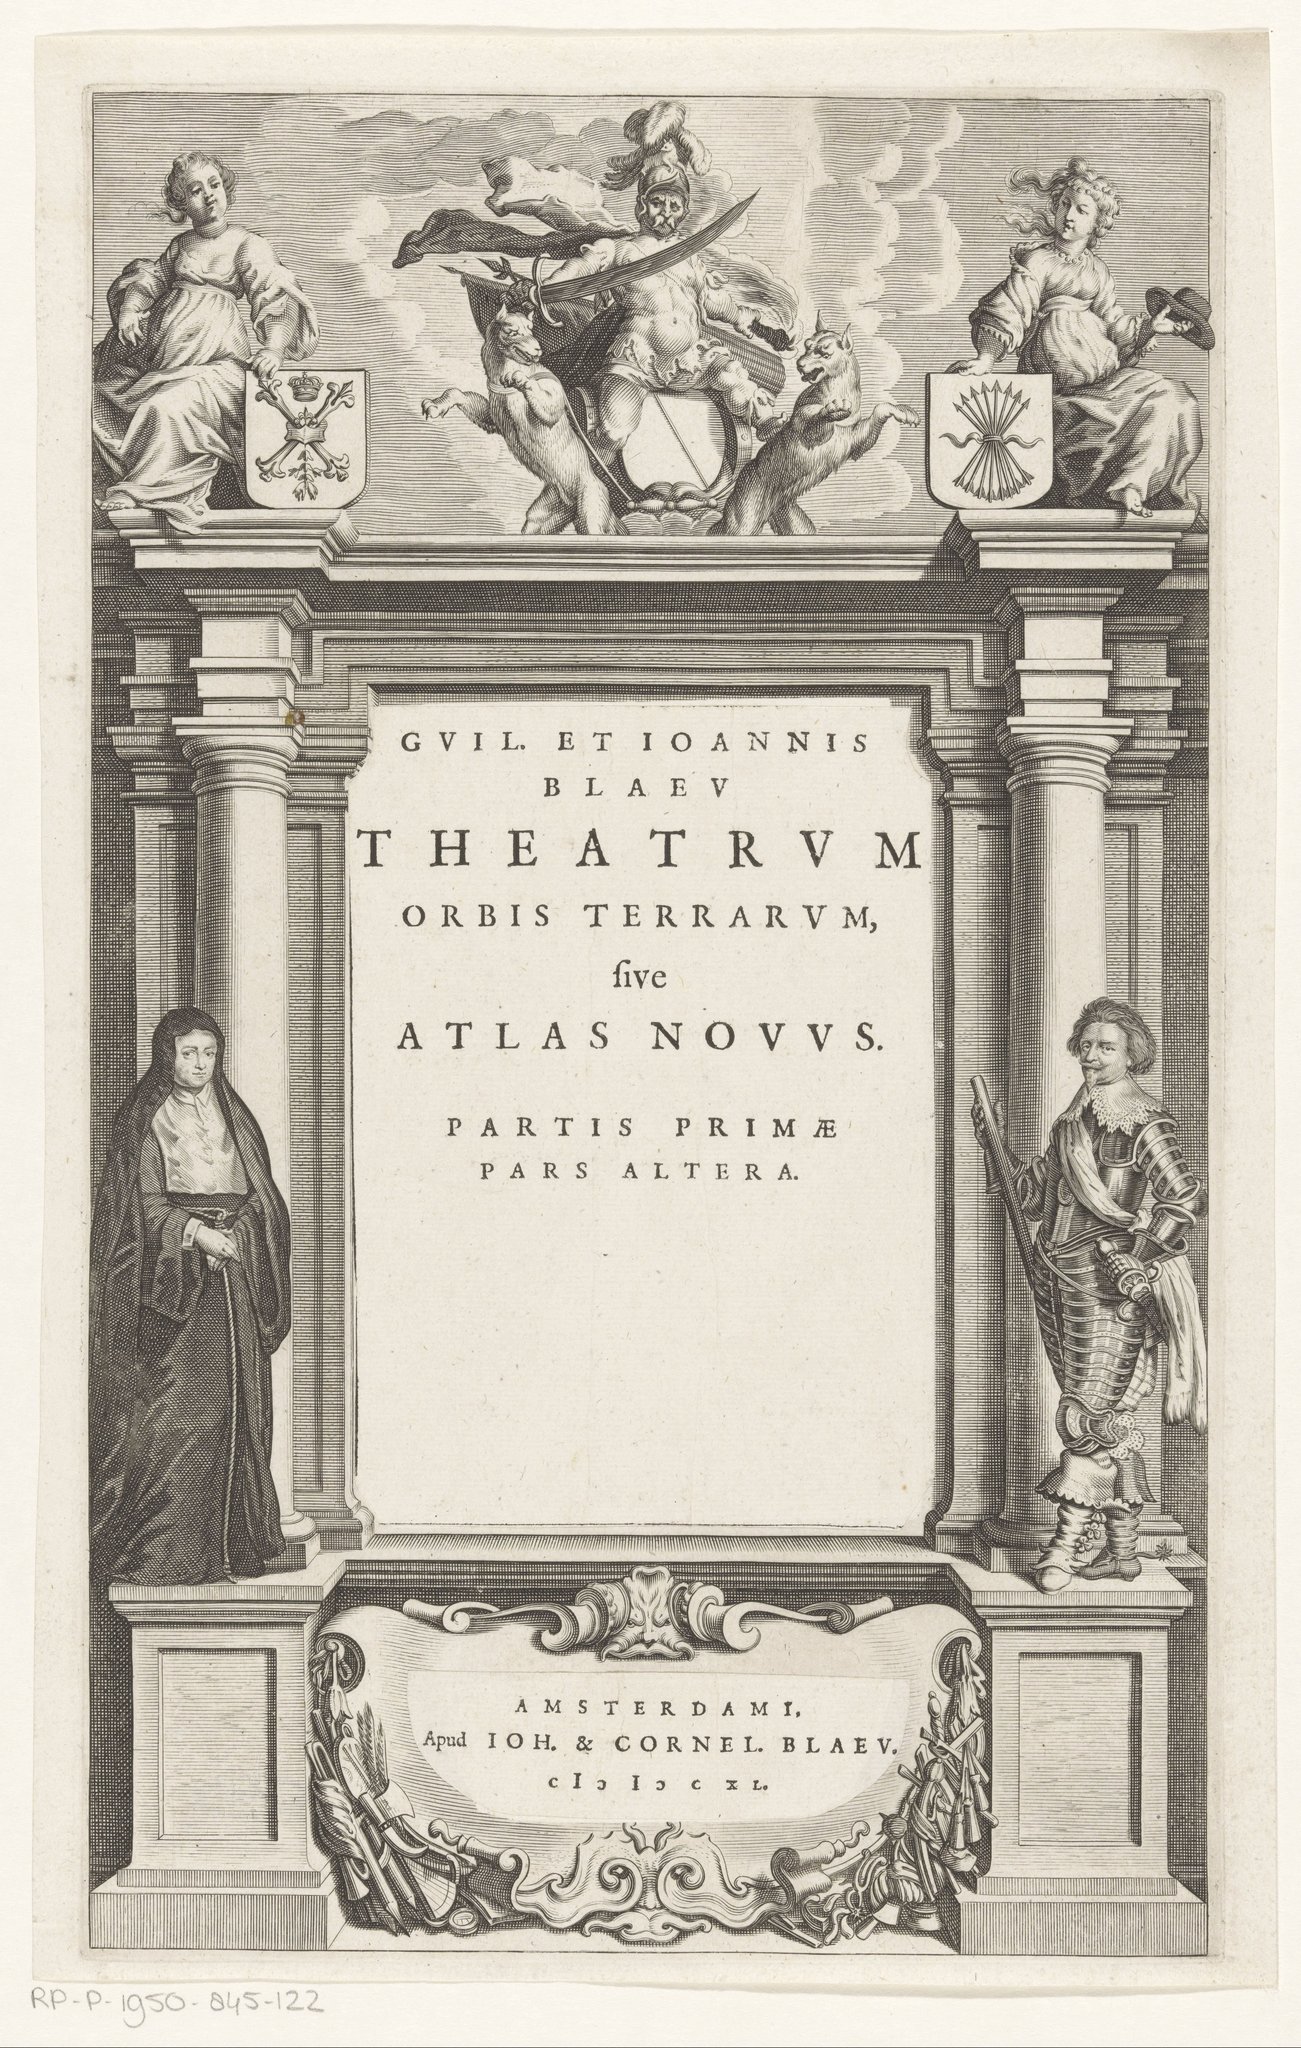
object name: titelblad, titelpagina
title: Titelpagina voor: Willem Blaeu en Johan Blaeu, Theatrum orbis terrarum, sive atlas novus, 1640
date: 1640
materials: paper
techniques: engraving, letterpress printing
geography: amsterdam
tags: frederick henry (prince of orange), amalia of solms-braunfels, (story of) mars (ares), historical persons (portraits and scenes from the life)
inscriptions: collector's mark: Lugt 2228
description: Titelpagina voor: Blaeu, Willem en Blaeu, Johan. Theatrum orbis terrarum, sive atlas novus. Amsterdam: Blaeu, Johannes Willemszoon en Blaeu, Cornelis, 1640. Prent afkomstig uit een plakalbum met titelprenten, ornamenten etc. op blauw papier in 1983 uit elkaar gehaald. Volgens een notitie op verso zat de prent op p. 122 van dit album.